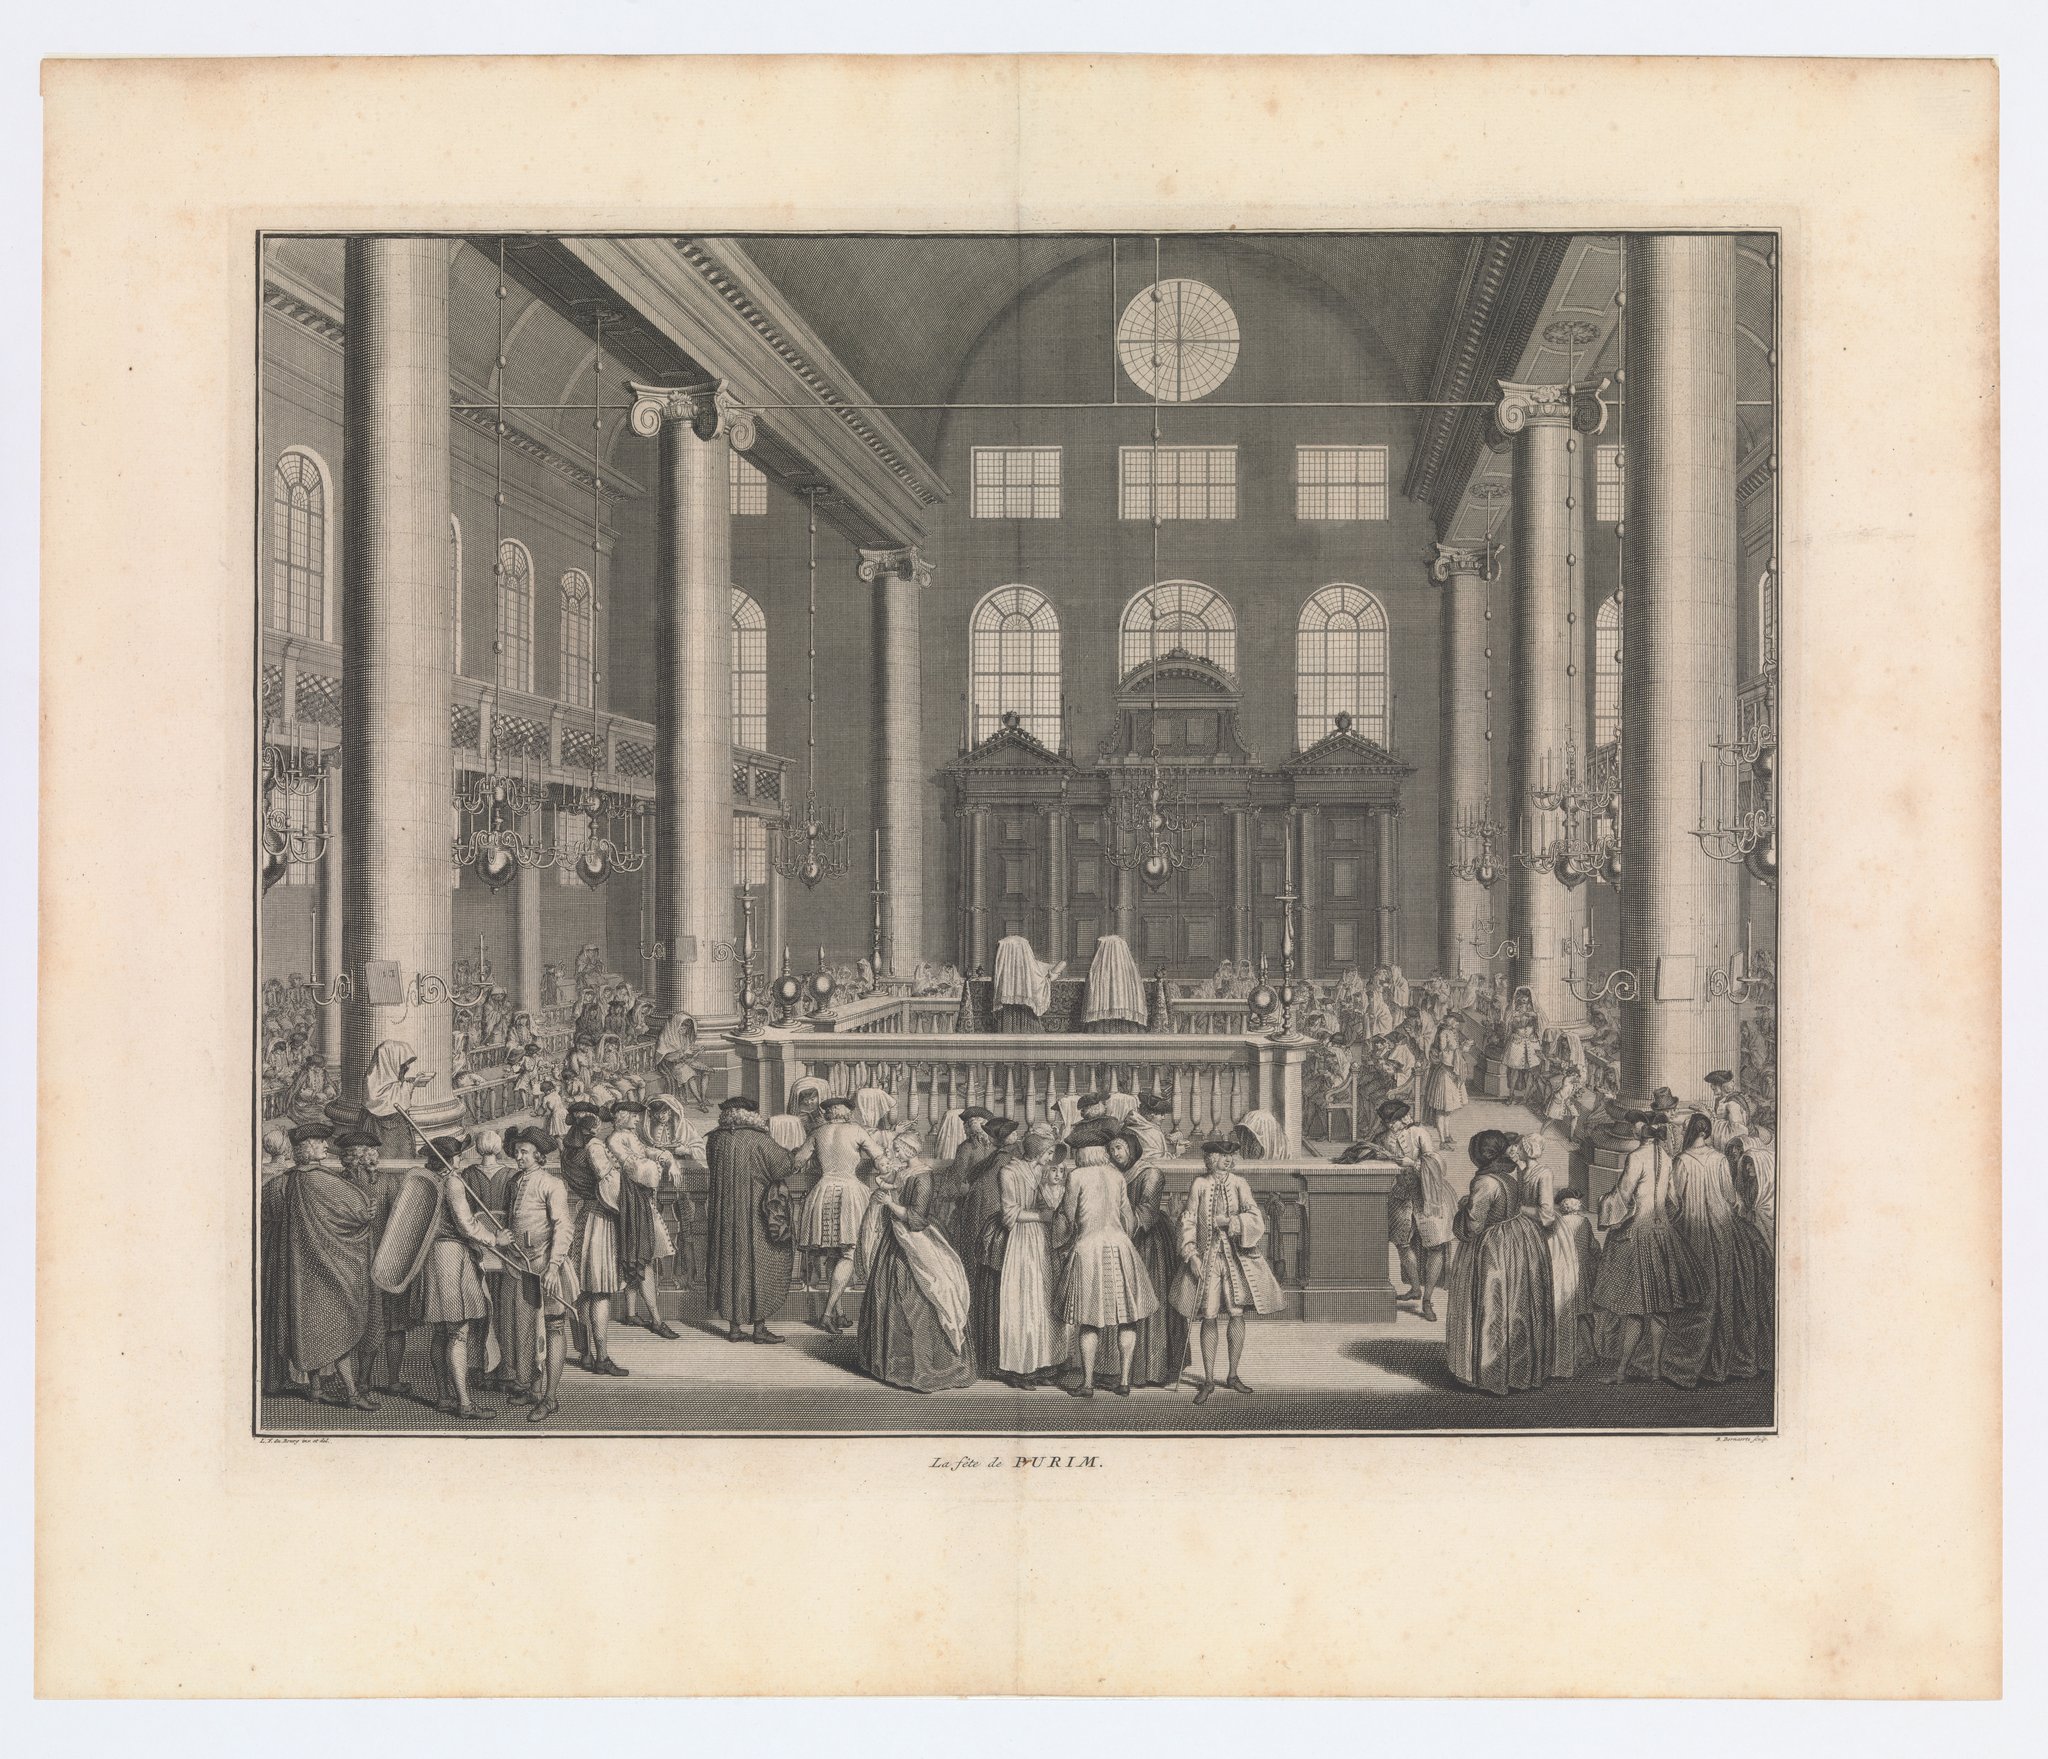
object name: print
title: The Festival of Purim (La fête de Purim); Interior of the Portuguese Synagogue in Amsterdam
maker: balthasar bernaerts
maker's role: artist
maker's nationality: dutch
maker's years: 1710-1737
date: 1737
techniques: engraving, etching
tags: synagogues